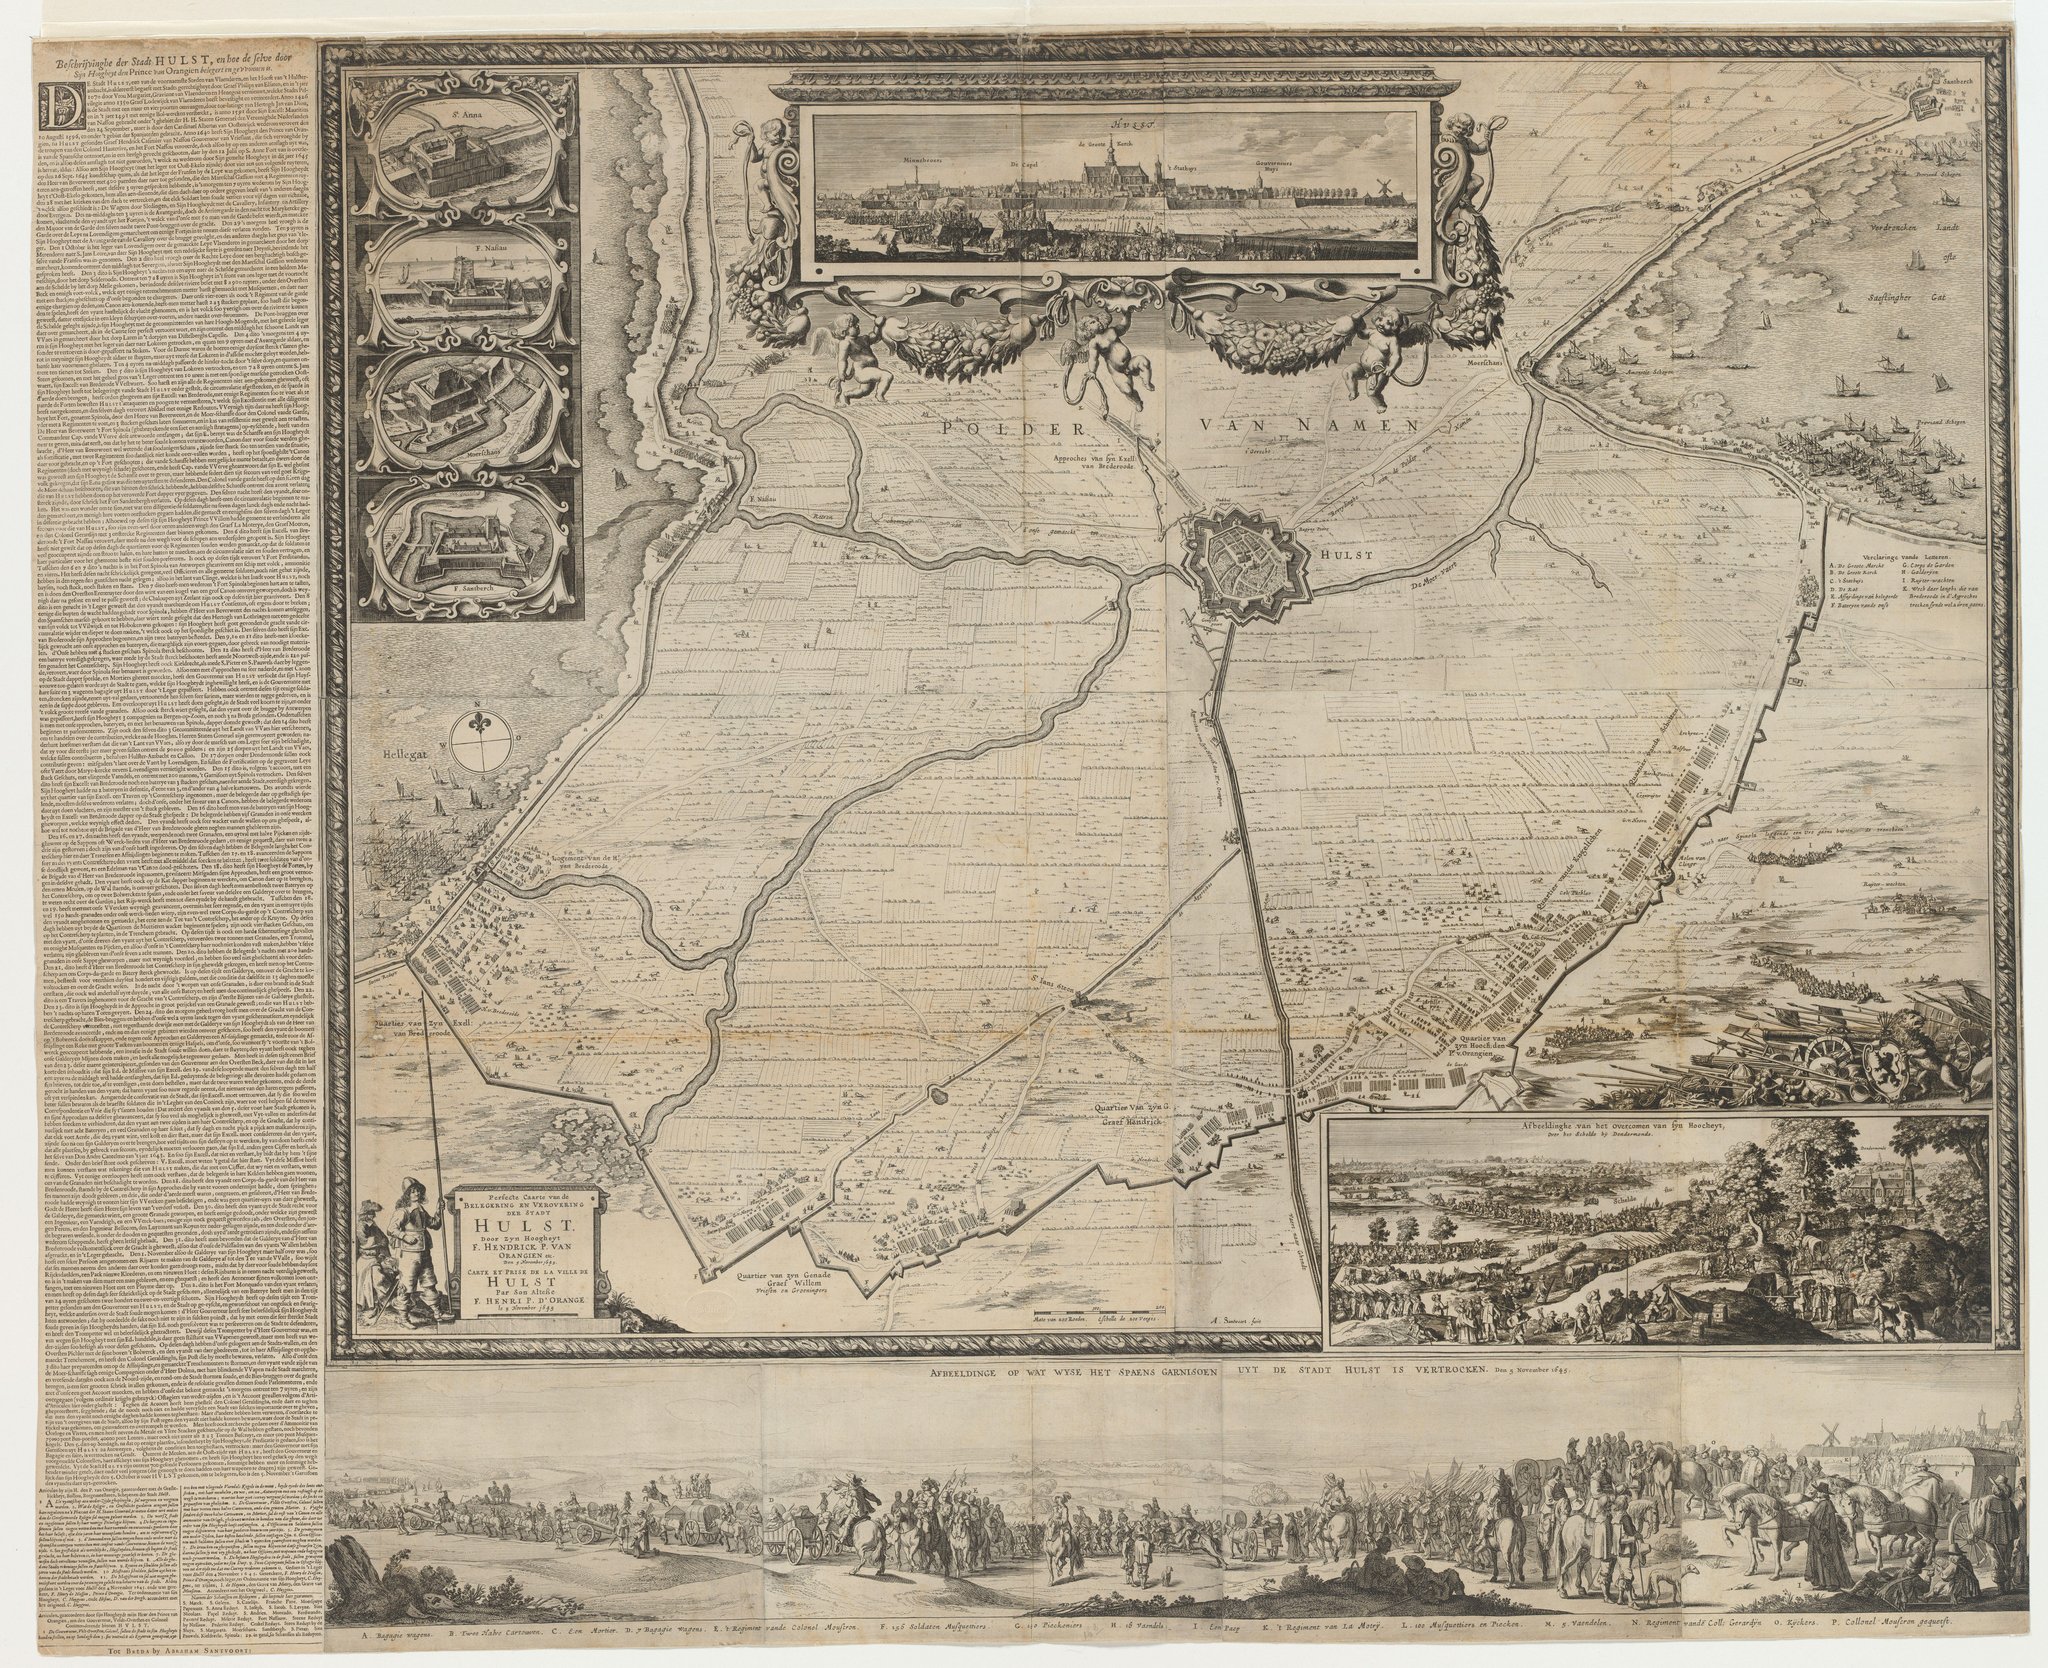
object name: map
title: Perfecte Caarte van de Belegering en Verovering der Stadt Hulst, Door zyn Hoogheyt F. Hendrick P. van Orangien etc. Den 5 November 1645 / Carte et Prise de la Ville de Hulst Par Son Altesse F. Henri P. d'Orange le 5 November 1645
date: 1645-1646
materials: paper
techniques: etching, letterpress printing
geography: breda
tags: delft, frederick henry (prince of orange), fortress, maps of separate countries or regions, siege, position war, retreat of the defeated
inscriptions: inscription: ‘Belegering van Hulst 1645./ met de uyttogt./ in het groot seer raar/ 1772.’, inscription: ‘Belegert door Pr Fredrik Hendrik/ in de stad commandeerde de Colonel der/ Spag[y]narden.’, collector's mark: ‘Ministerie van Oorlog. Archief. Afdeeling Genie’, inscription: ‘Veldslagen/ 704.’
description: Beleg en verovering van Hulst door het Staatse leger onder Frederik Hendrik van 28 september tot 5 november 1645. Samengevoegde kaart bestaande uit een grote kaart van het beleg in vier bladen, een tekstblad in het Nederlands (zie andere exemplaar voor het Franse tekstblad) en de uittocht van het Spaanse garnizoen in twee bladen.